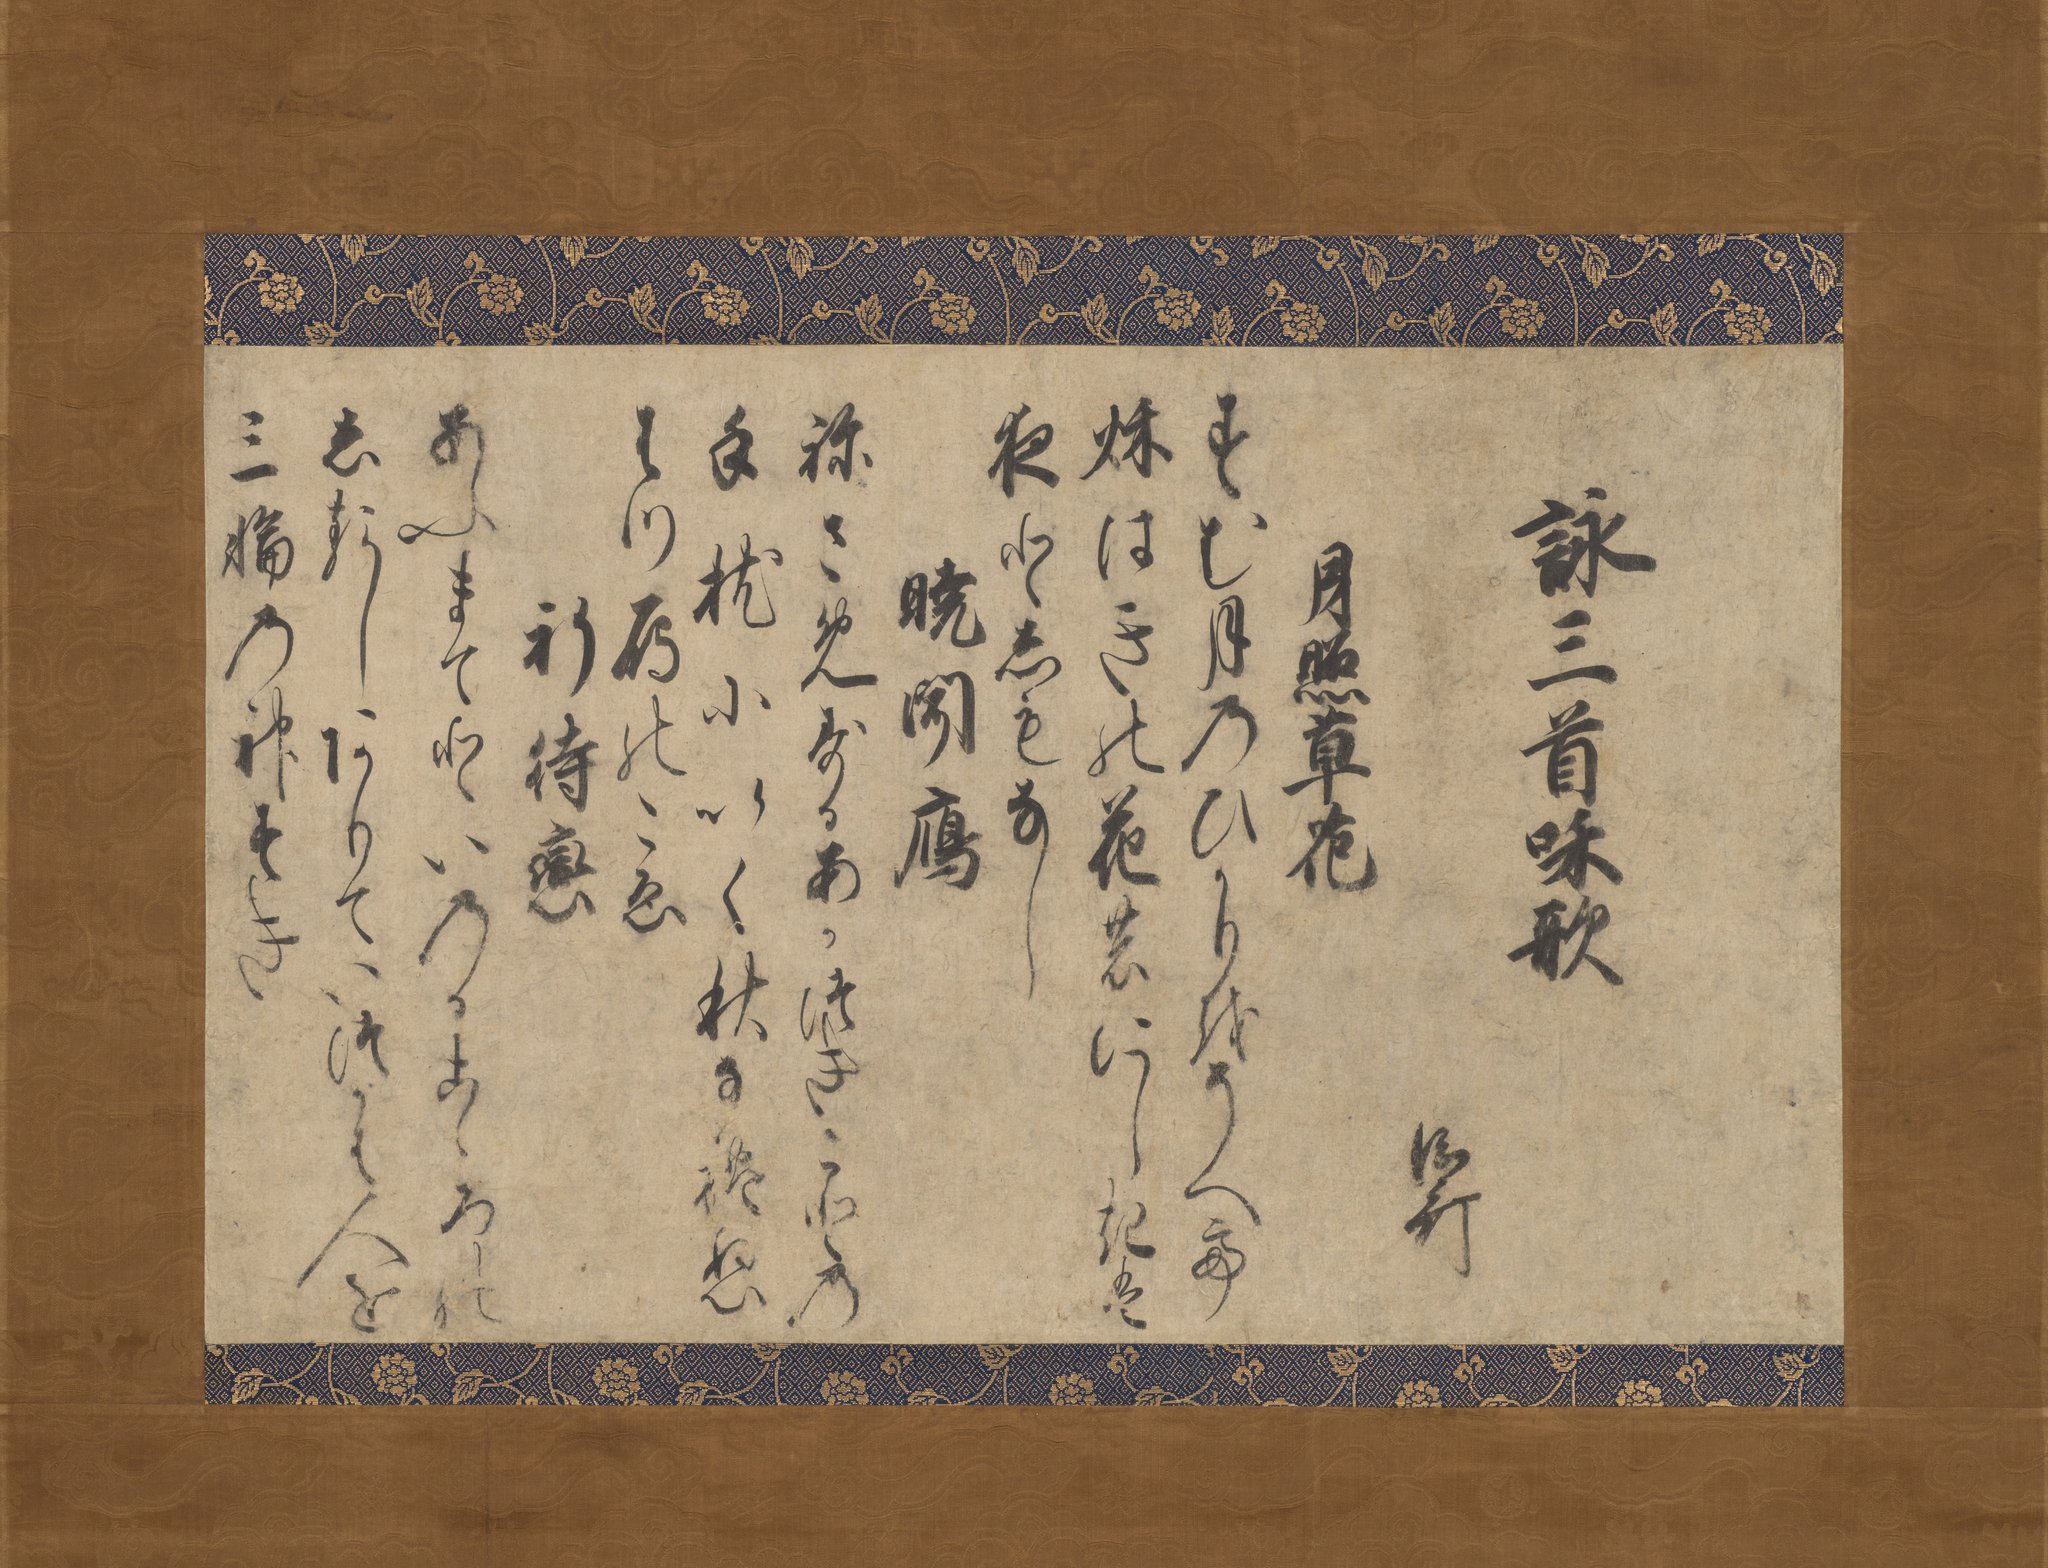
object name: hanging scroll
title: Three Waka Poems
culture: japanese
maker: jōben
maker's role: artist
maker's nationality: japanese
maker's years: 1256-1356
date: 1301-1333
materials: ink, paper